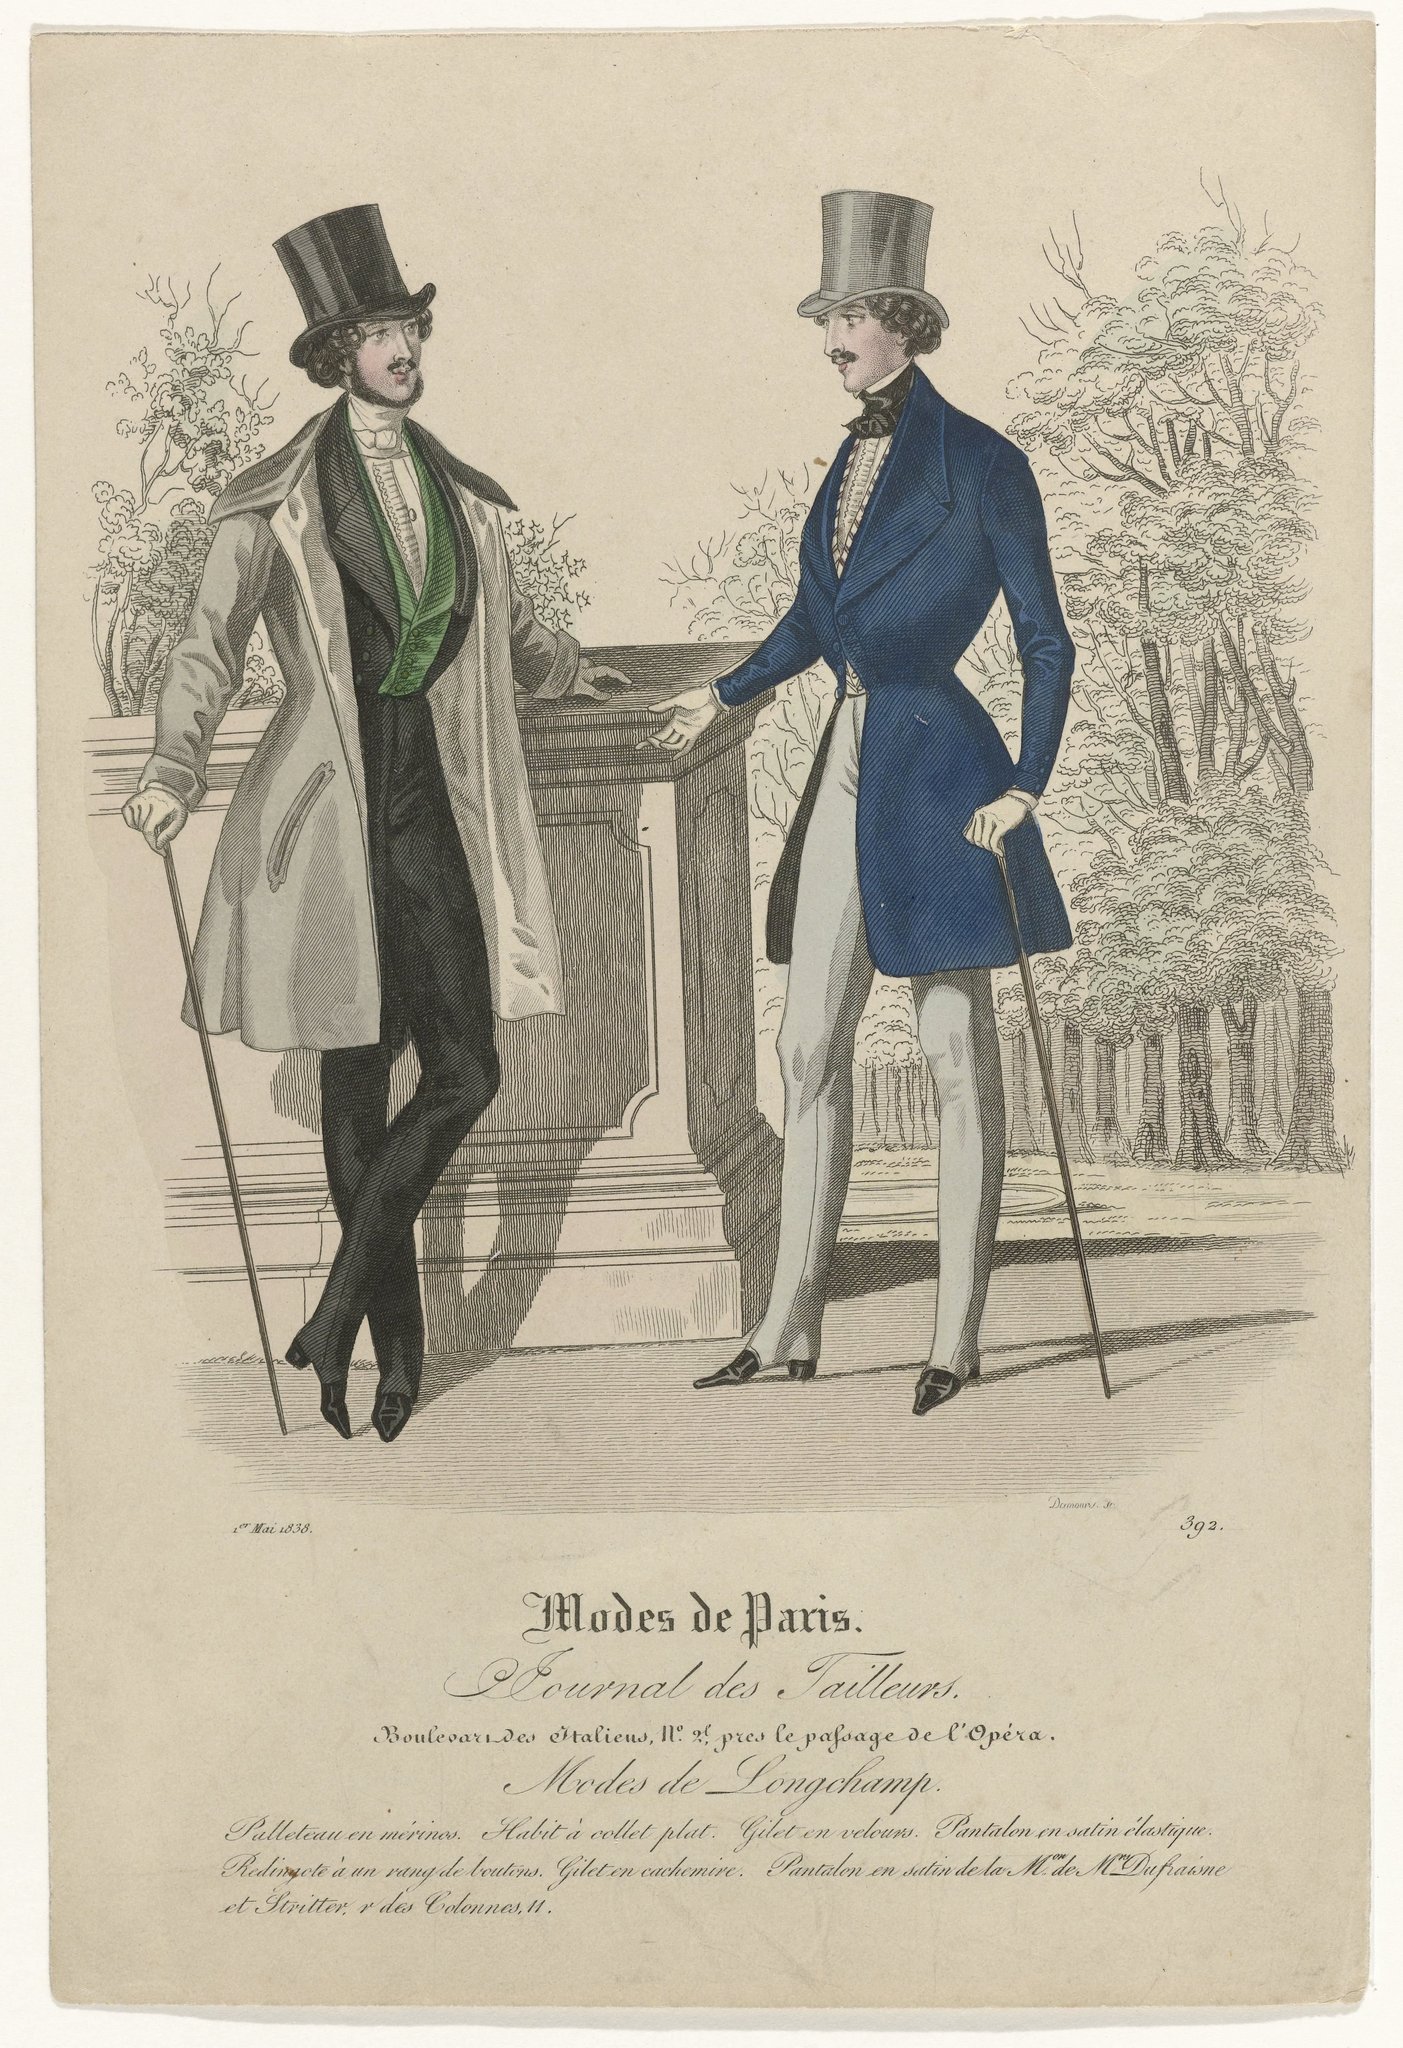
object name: fashion print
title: Journal des Tailleurs, Modes de Paris, 1 mai 1838, No. 392 : Modes de Longchamp (...)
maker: damours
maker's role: print maker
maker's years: 1797-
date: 1838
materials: paper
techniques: engraving, hand coloring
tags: clothing for the upper part of the body (vest) (+ men's clothes), neck-gear ~ clothing (neckerchief) (+ men's clothes), trousers, breeches, etc. (pantalon) (+ men's clothes), coat: overcoat (+ men's clothes), coat (+ men's clothes), fashion plates, walking-stick, staff, cane (+ men's clothes)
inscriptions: title: ‘Modes de Paris. Journal des Tailleurs’, check stamp, address: ‘Boulevart des Italiens, No. 2l pres le passage de l'Opéra.’, caption: ‘Modes de Longchamp. / Palleteau en mérinos. Habit à collet plat. Gilet en velours. Pantalon en satin élastique. Redingote à un rang de boutons. Gilet en cachemire. Pantalon en satin de la M.on de Mrs Dufraisne et Stritter, r des Colonnes, 11.’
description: Twee mannen in een park. Volgens het onderschrift:´modes de Longchamp.' Links: ´palleteau´van merinowol. ´Habit´ met platte kraag. Vest van fluweel. Lange broek (spanbroek) van ´satin élastique´. Rechts: redingote met één rij knopen. Vest van kasjmier. Lange broek (spanbroek) van satijn van de firma van Dufraisne et Stritter. Prent uit het modetijdschrift Journal des Tailleurs (1830-1896).